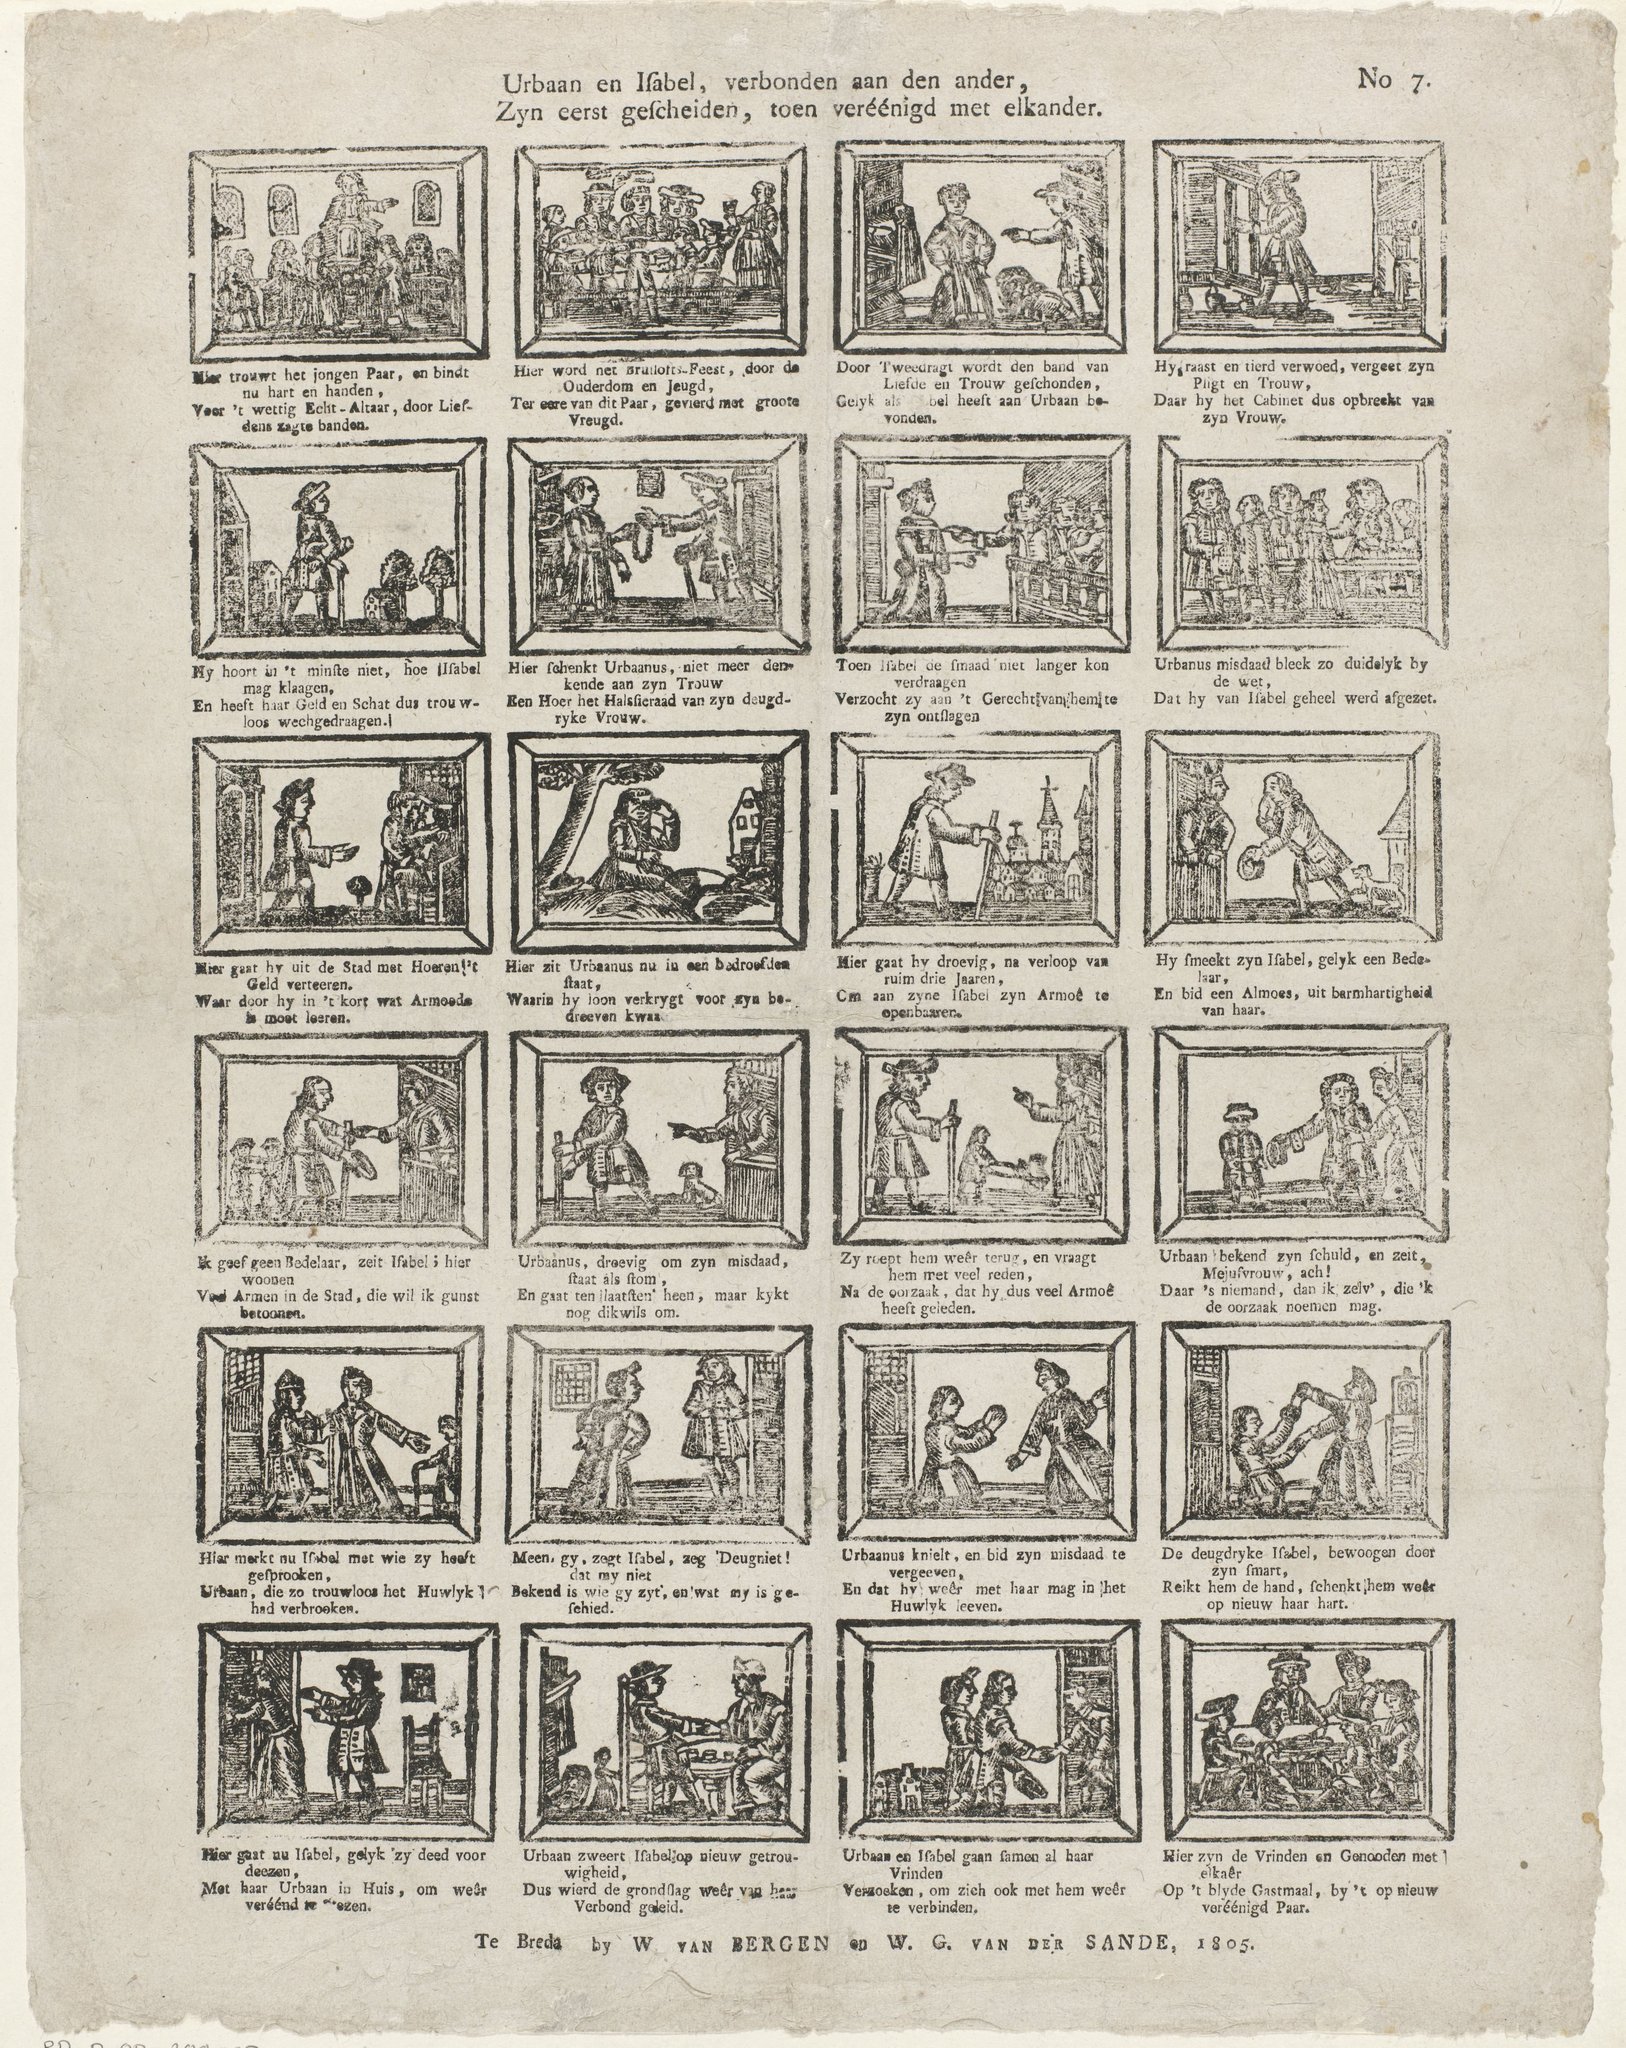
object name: popular print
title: Urbaan en Isabel, verbonden aan den ander, / Zyn eerst gescheiden, toen veréénigd met elkander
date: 1805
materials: paper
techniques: letterpress printing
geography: breda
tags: divorce, beggar, man and wife quarrelling, 'marriage à la mode'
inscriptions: collector's mark: Lugt 2760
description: Blad met 24 voorstellingen uit het leven van Urbanus en Isabel. Ze trouwen, maken ruzie, gaan scheiden, en Urbanus wordt een bedelaar. Onder elke afbeelding een vers. Genummerd rechtsboven: No. 7.